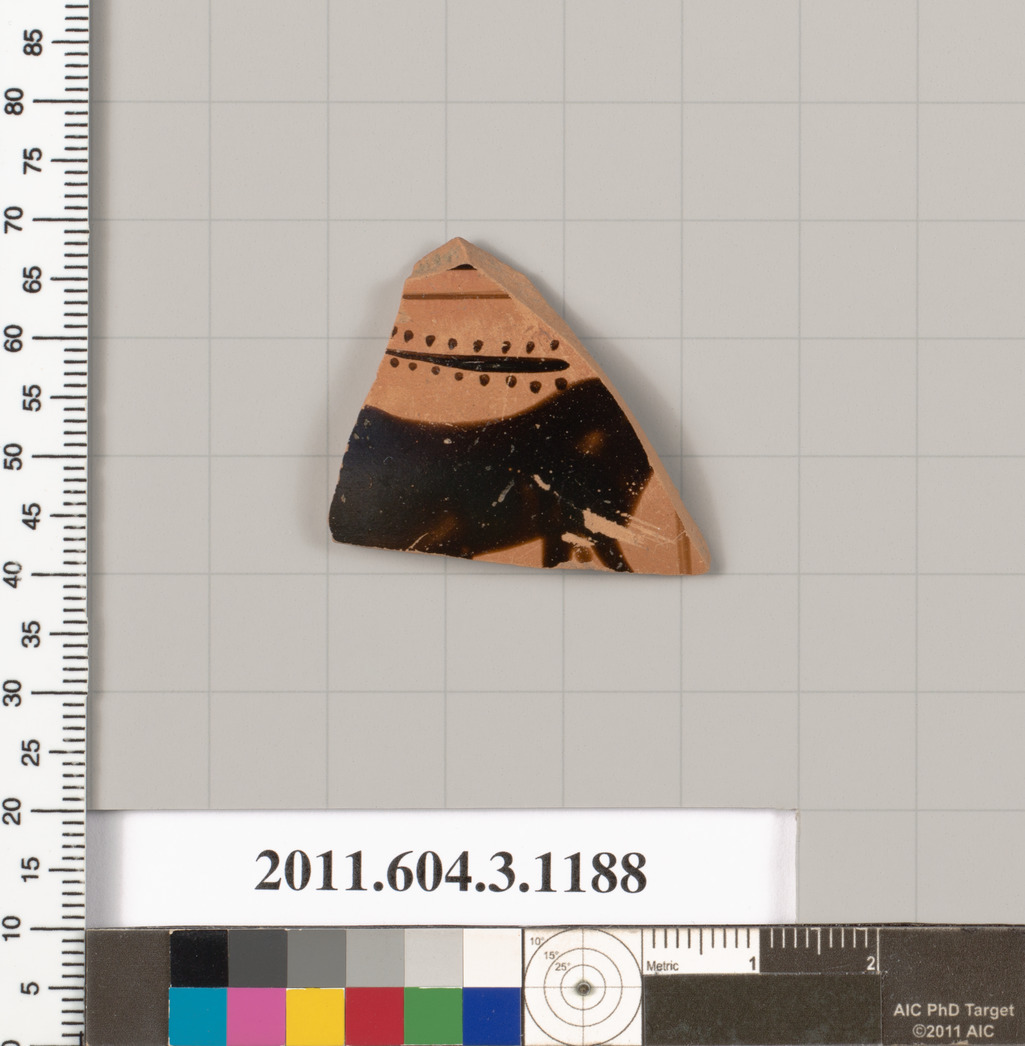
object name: mastoid fragment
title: Terracotta fragment of a mastoid (drinking cup with narrow base)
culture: greek, attic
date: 534-468 BCE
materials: terracotta